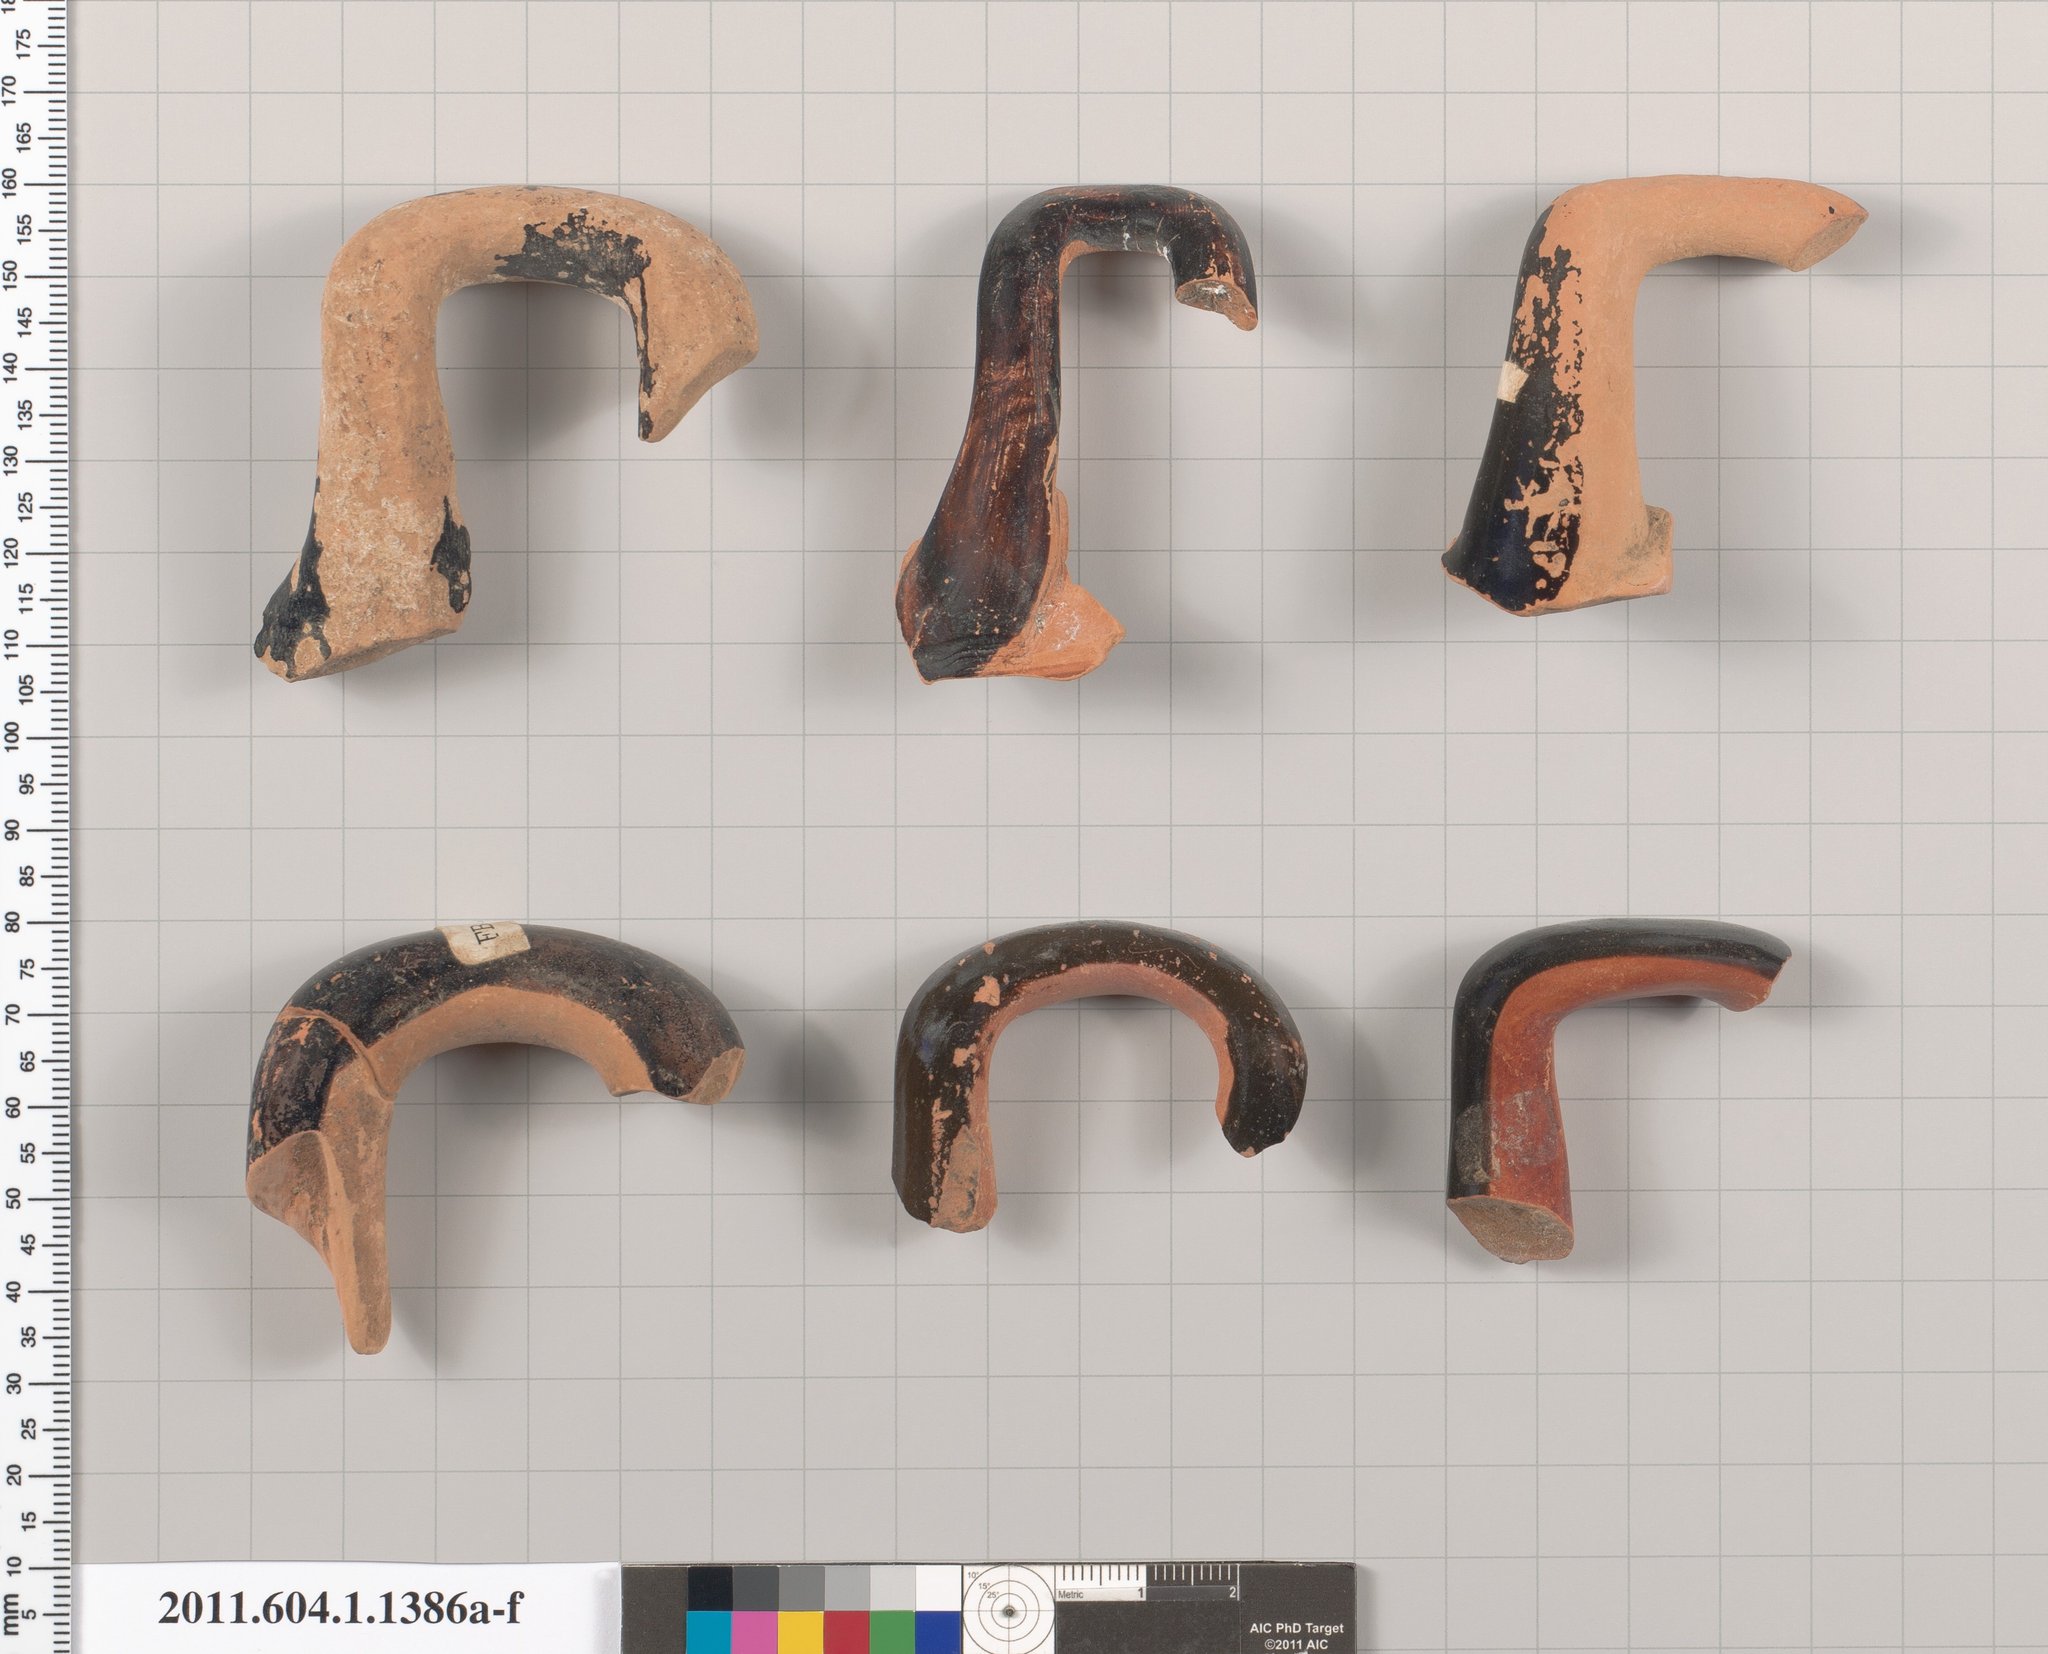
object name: kylix fragment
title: Terracotta fragments of kylikes (drinking cups)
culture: greek, attic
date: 500-401 BCE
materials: terracotta